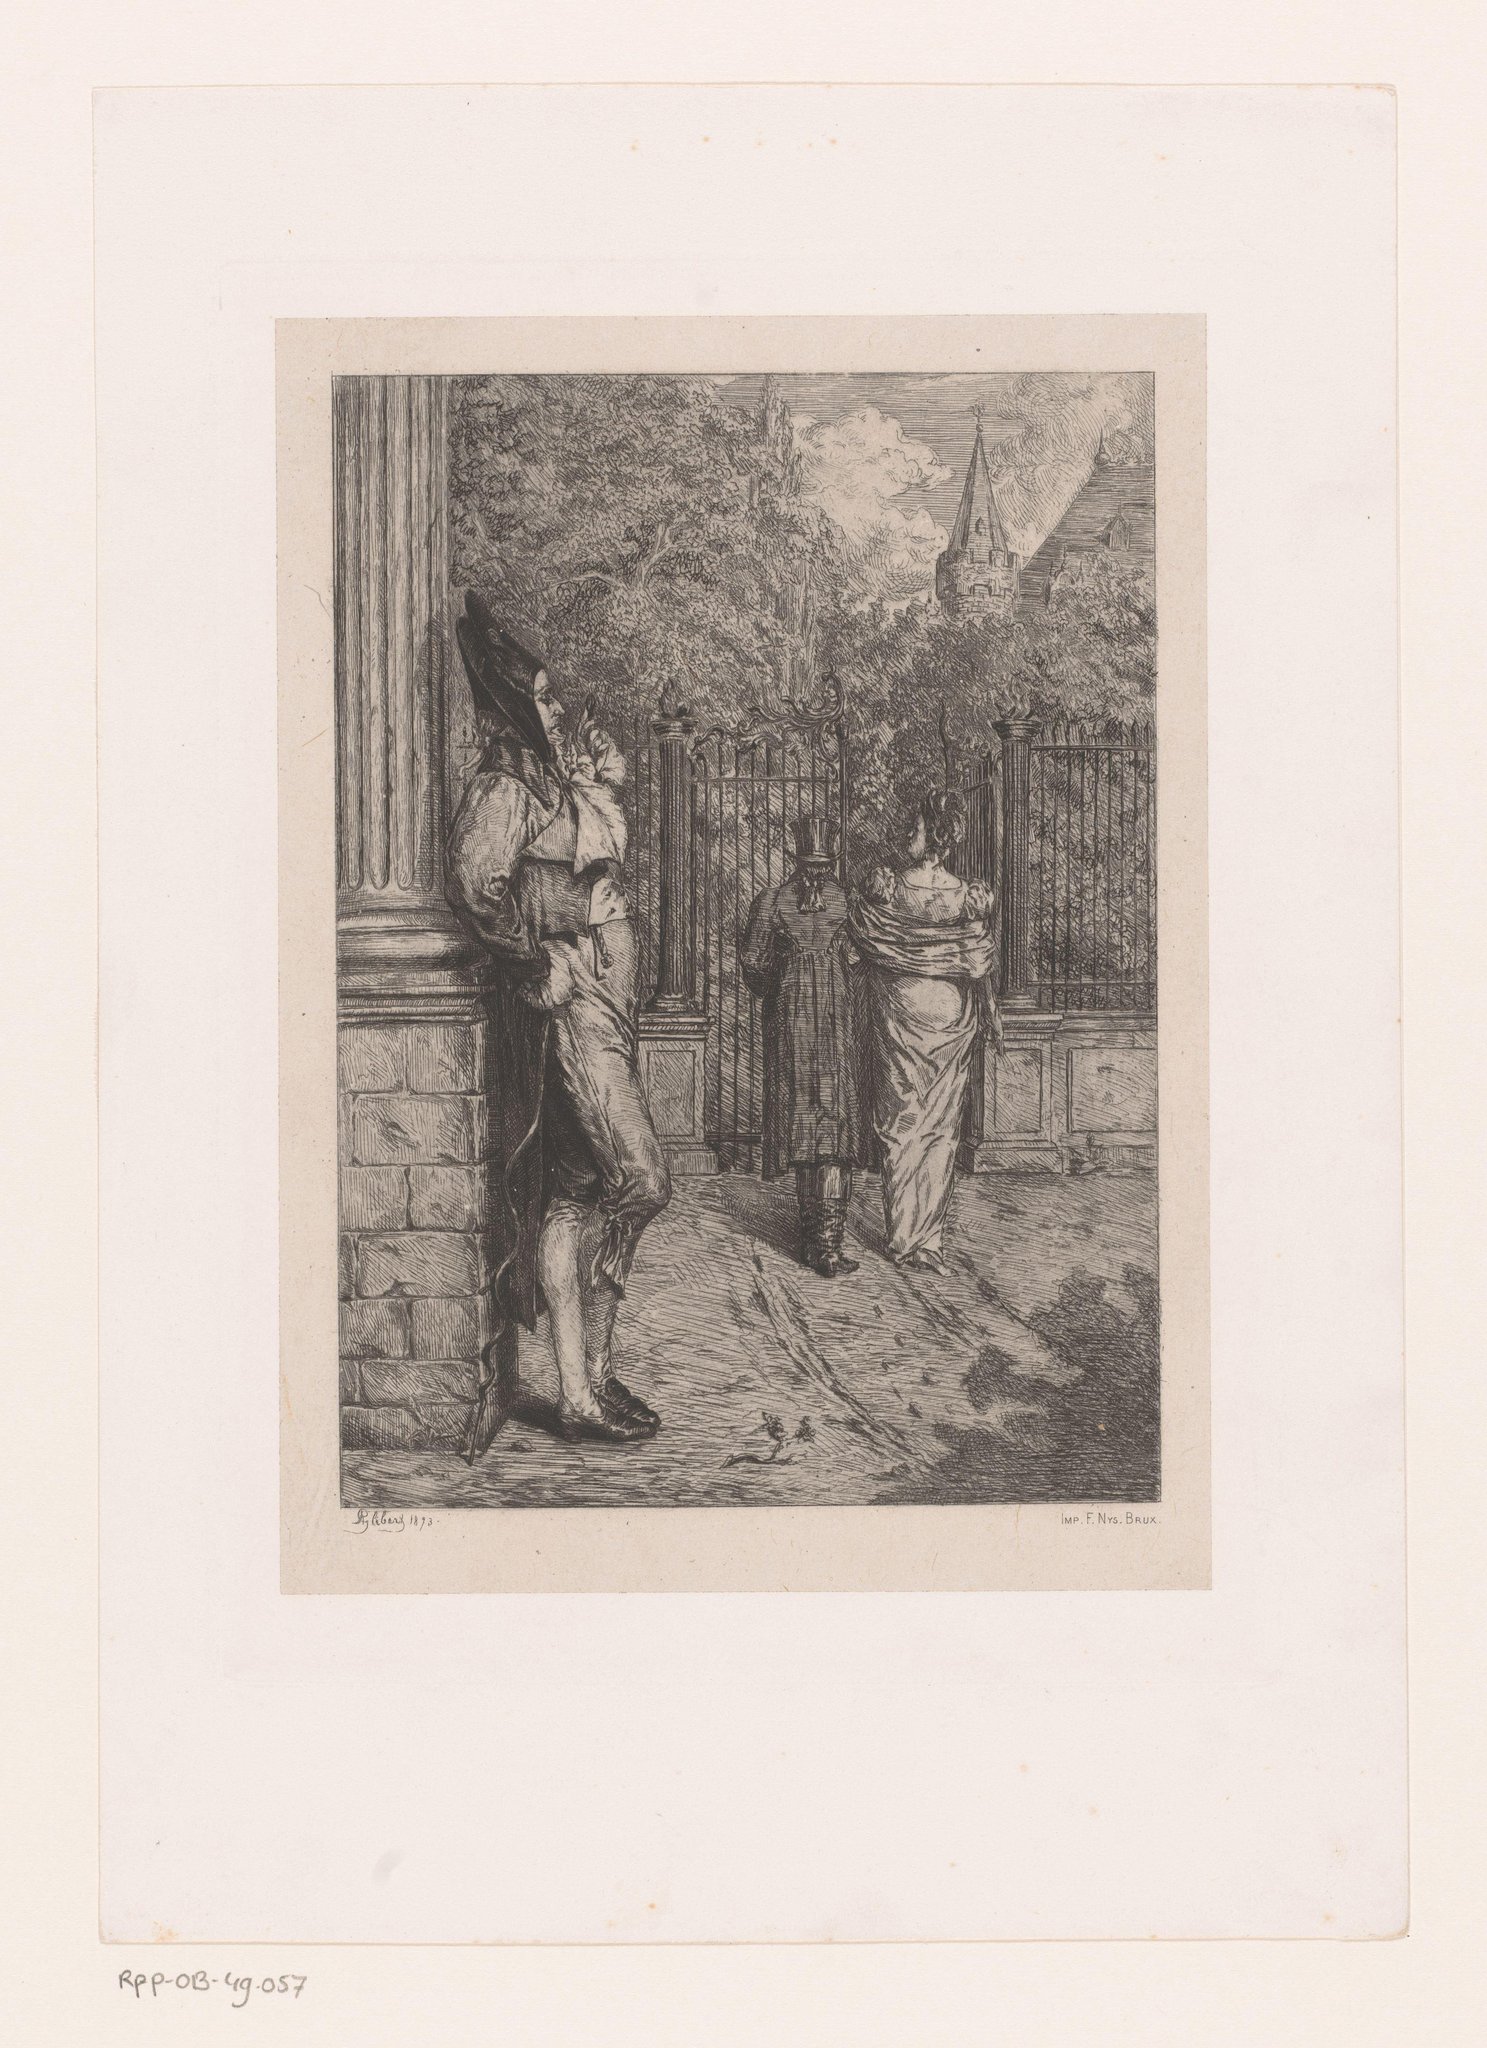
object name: print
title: Man links kijkt naar een koppel dat het park in wandelt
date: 1873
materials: paper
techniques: etching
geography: brussels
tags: park, castle, couple of lovers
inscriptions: collector's mark: Lugt 2228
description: Prent verschenen in: Album du journal des Beaux-Arts, dix eaux-fortes inédites. Antwerpen: Typographie A. Fontaine, 1873.